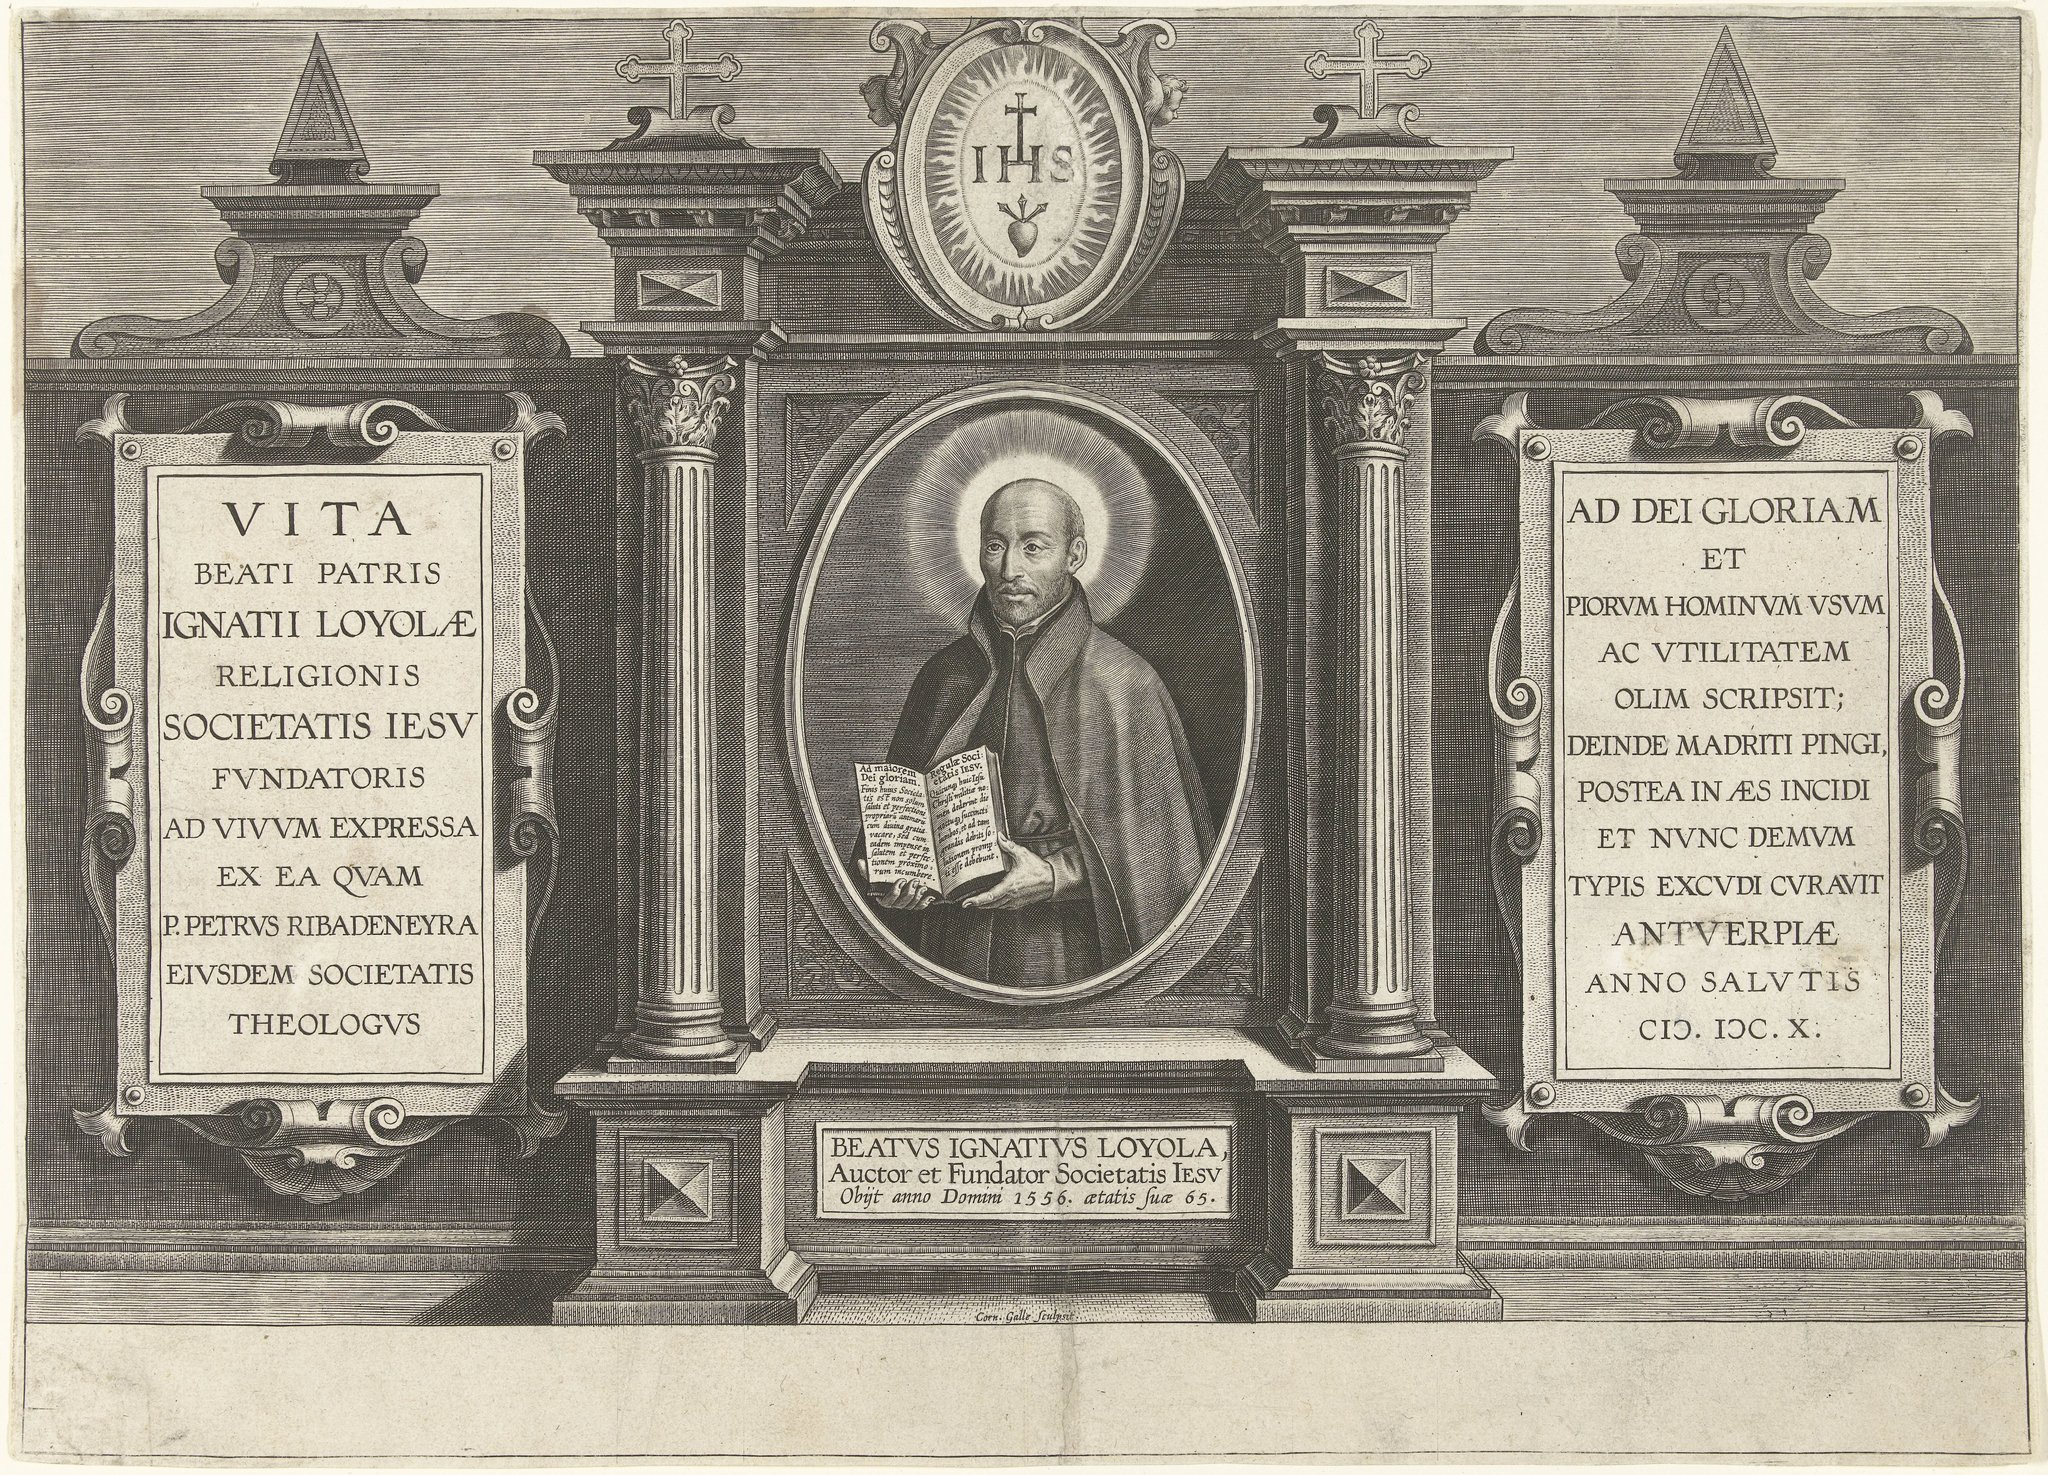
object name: print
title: Scènes uit het leven van Ignatius van Loyola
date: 1610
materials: paper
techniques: engraving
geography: antwerp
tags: rome, clergyman, the founder of the jesuit order, ignatius of loyola; possible attributes: book (with 'ad majorem dei gloriam'), demon, dragon under feet, flames, flaming heart, globe, ihs monogram, skull (with crown), tears in eyes, torch - portrait of male saint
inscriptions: collector's mark: Lugt 2228, collector's mark: Lugt 2760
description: Centraal het portret van Ignatius van Loyola in ovaal kader. Buste naar links. Hij houdt een boek open waarin de regels van de Jezuïetenorde staan geschreven. Het portret staat tussen twee zuilen. Boven het monogram van de Jezuïetenorde IHS en het Heilig Hart. Links en rechts twee opschriften met Latijnse tekst en de titel van de serie.